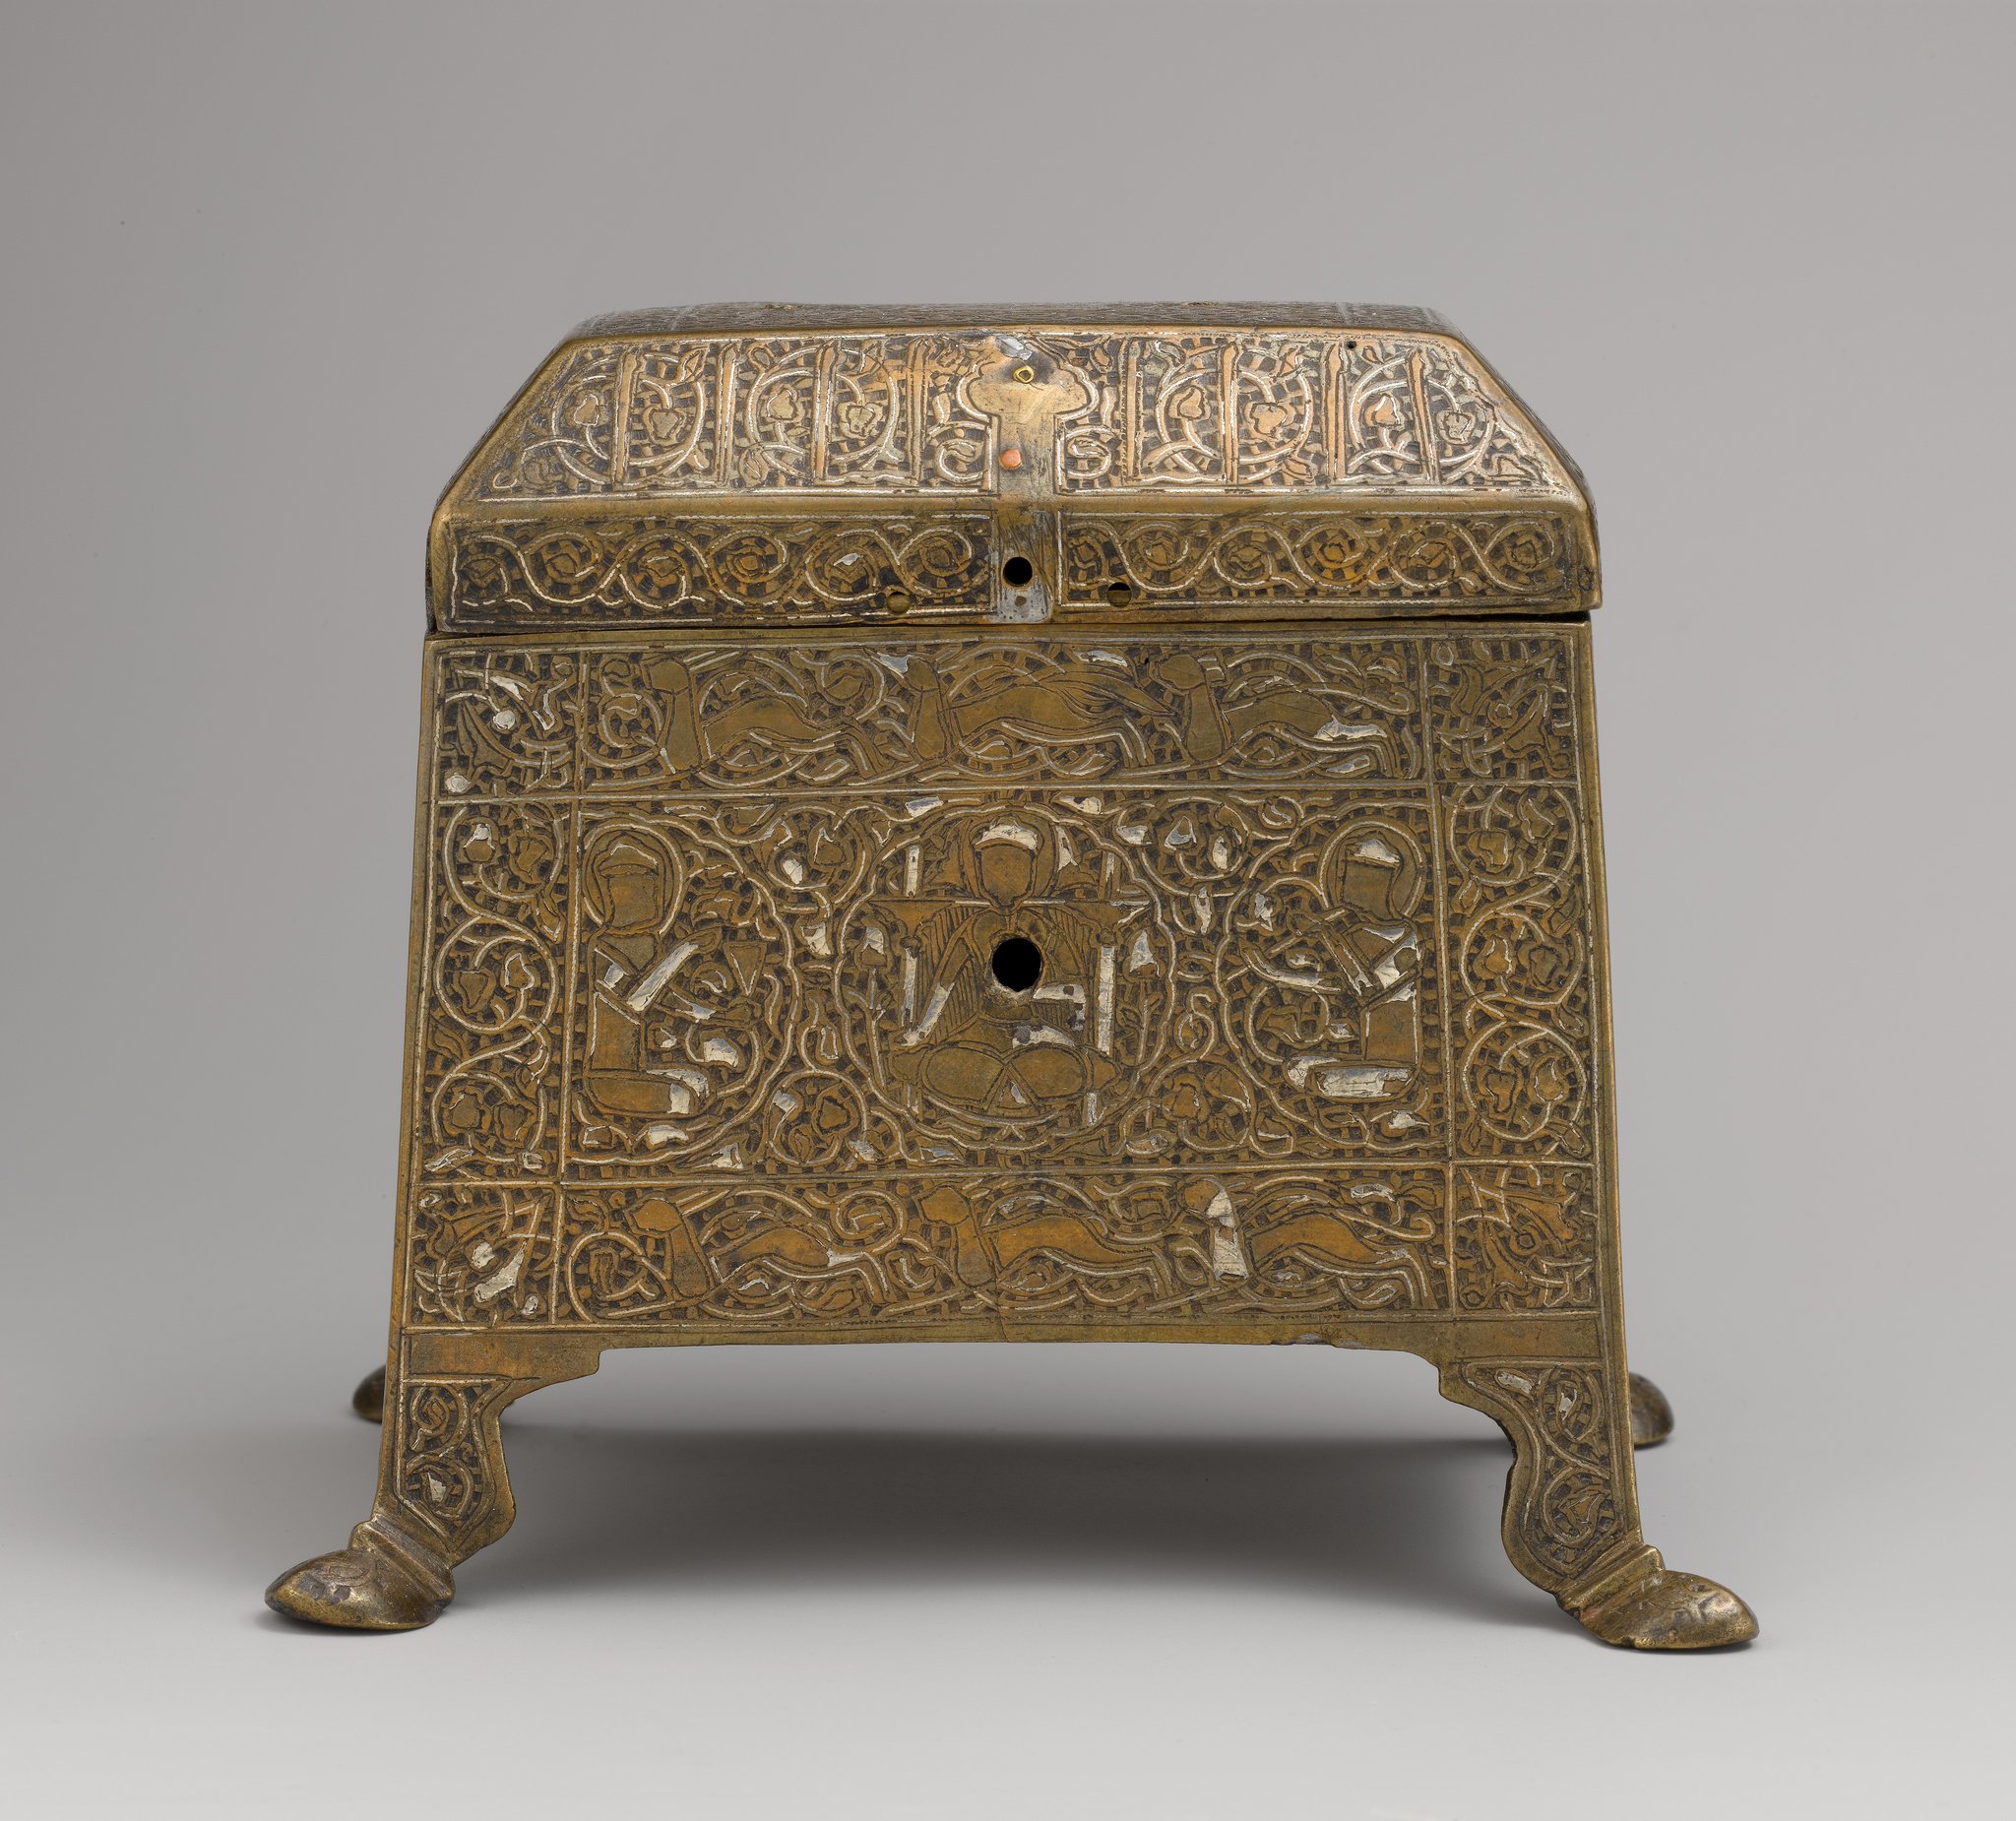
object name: casket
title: Casket with Figural Imagery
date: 1234-1266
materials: brass, metal, silver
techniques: inlay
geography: iran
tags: human figures,animals